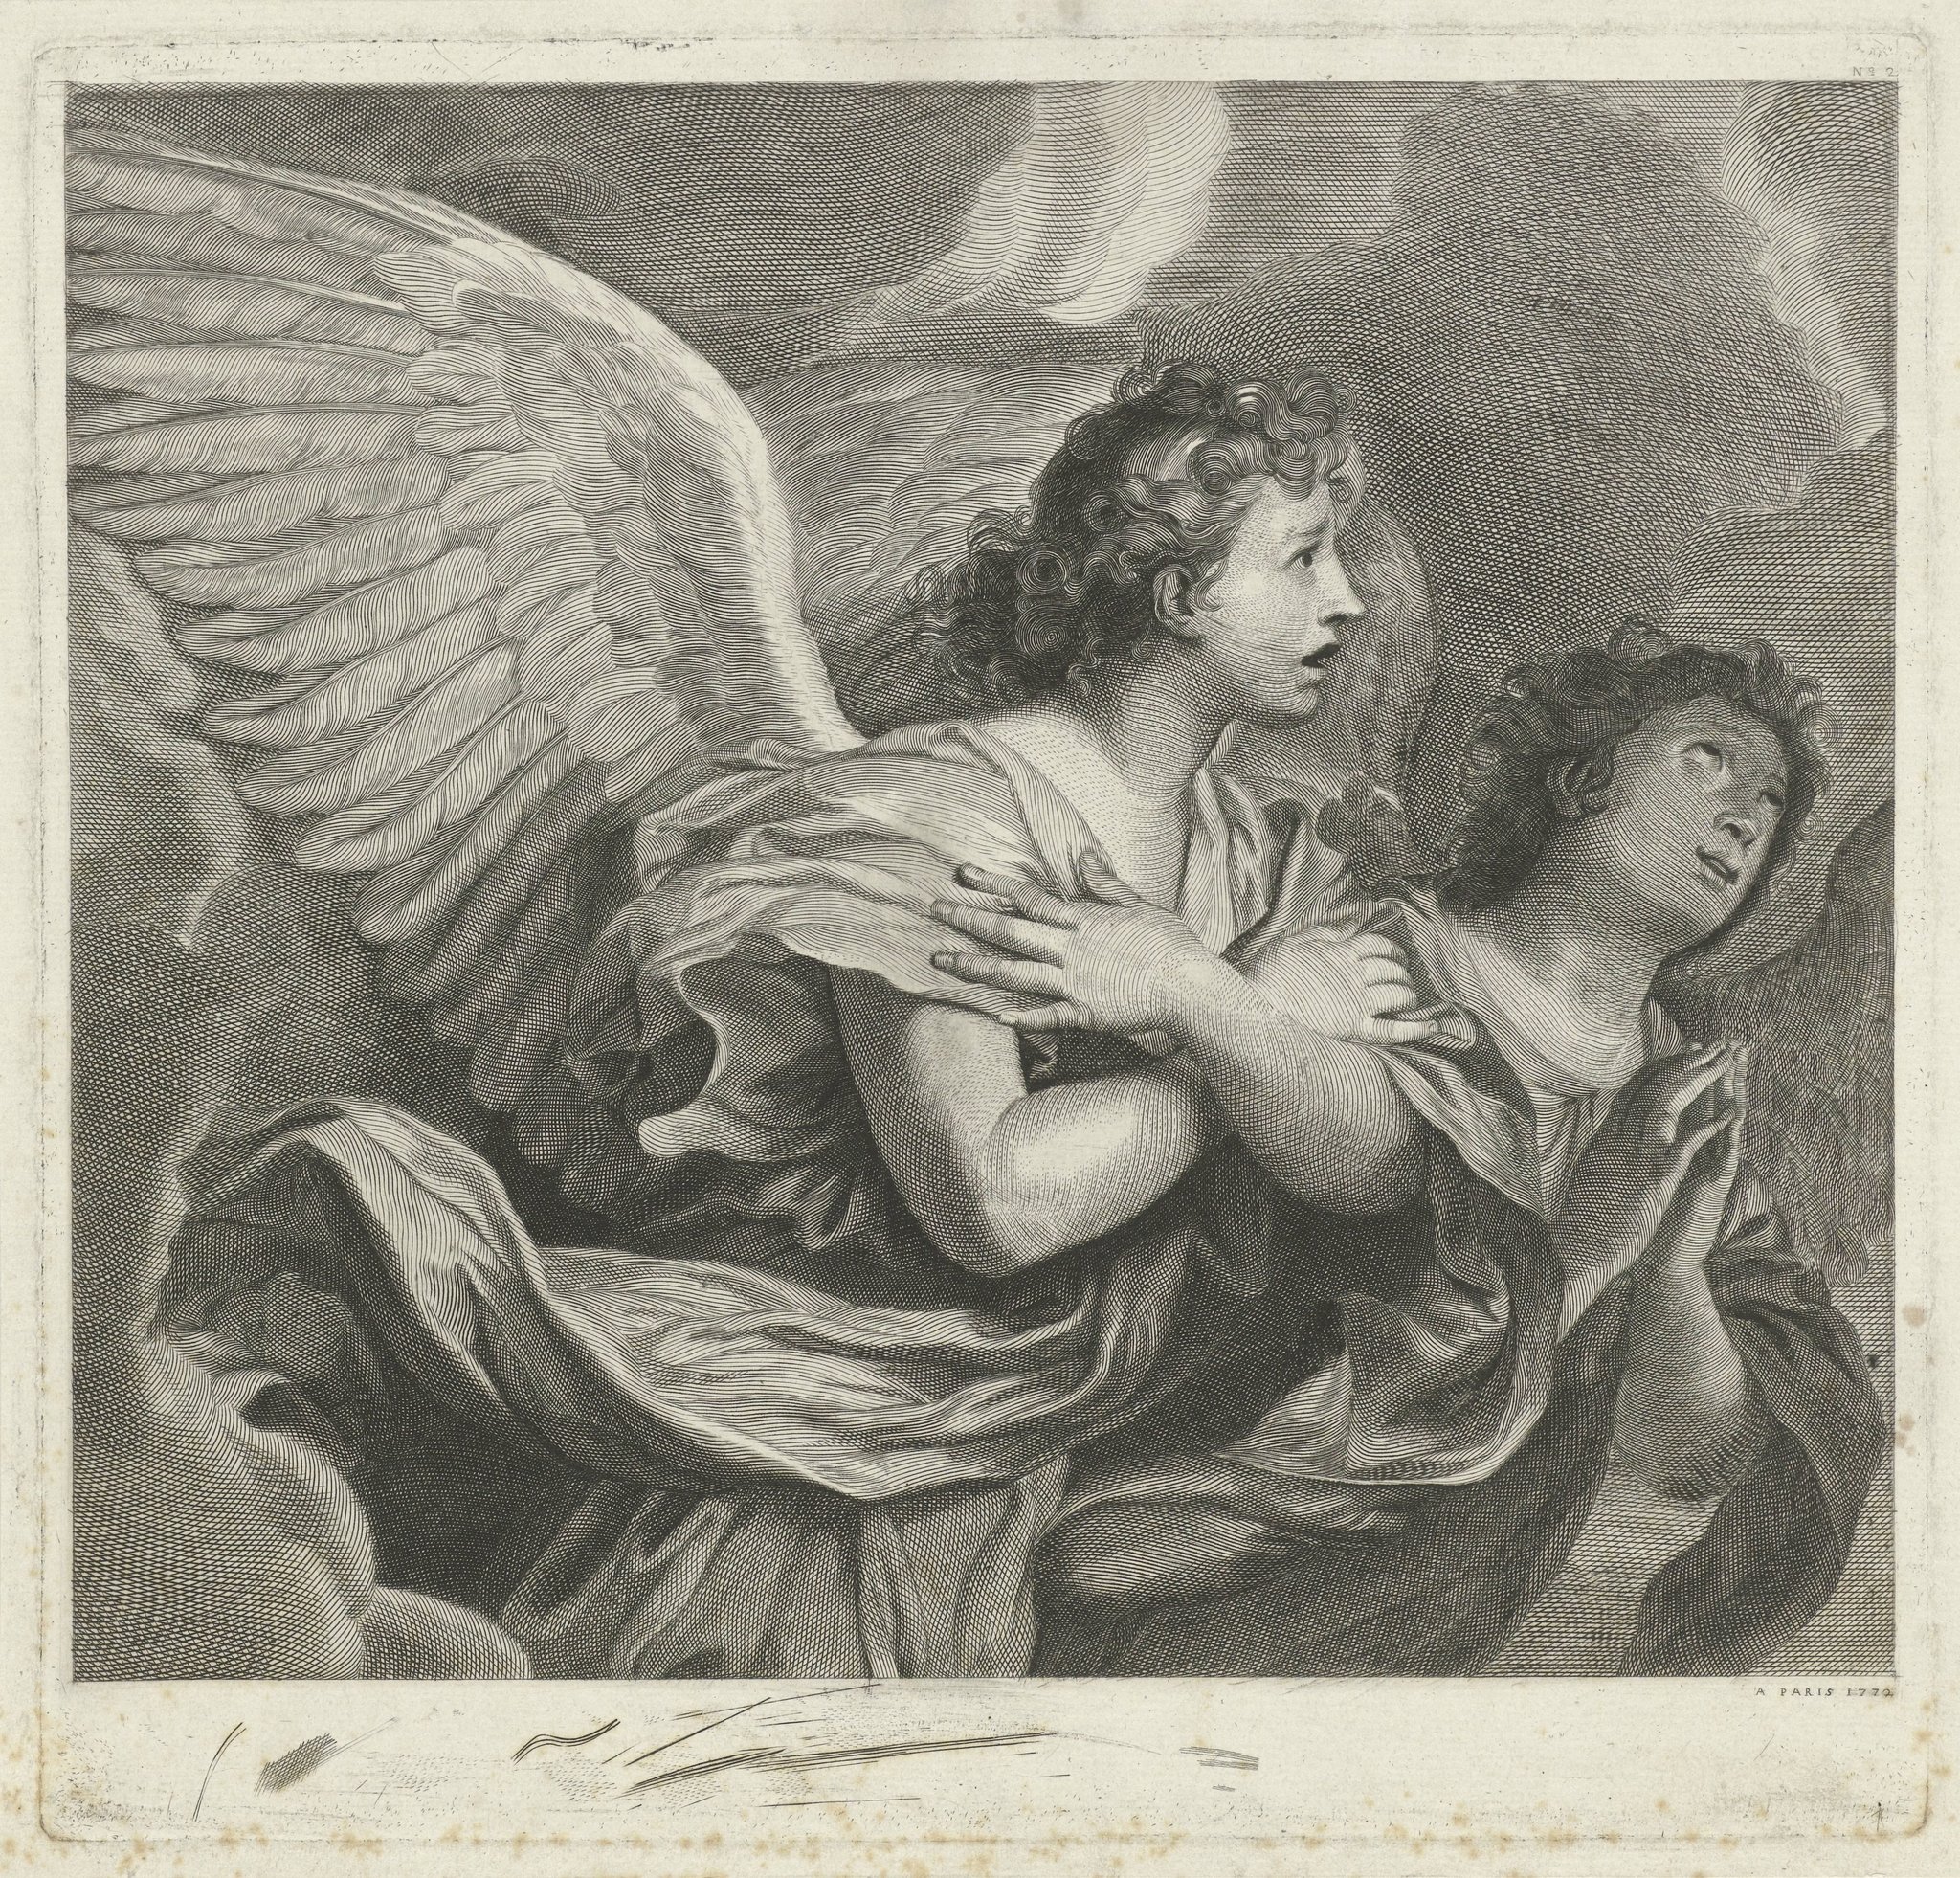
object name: print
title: Twee engelen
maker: pieter willem van megen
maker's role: print maker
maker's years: 1750-1785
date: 1772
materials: paper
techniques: engraving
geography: paris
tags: angels in adoration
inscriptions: collector's mark: Lugt 240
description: Twee engelen in aanbidding kijkend naar rechts.